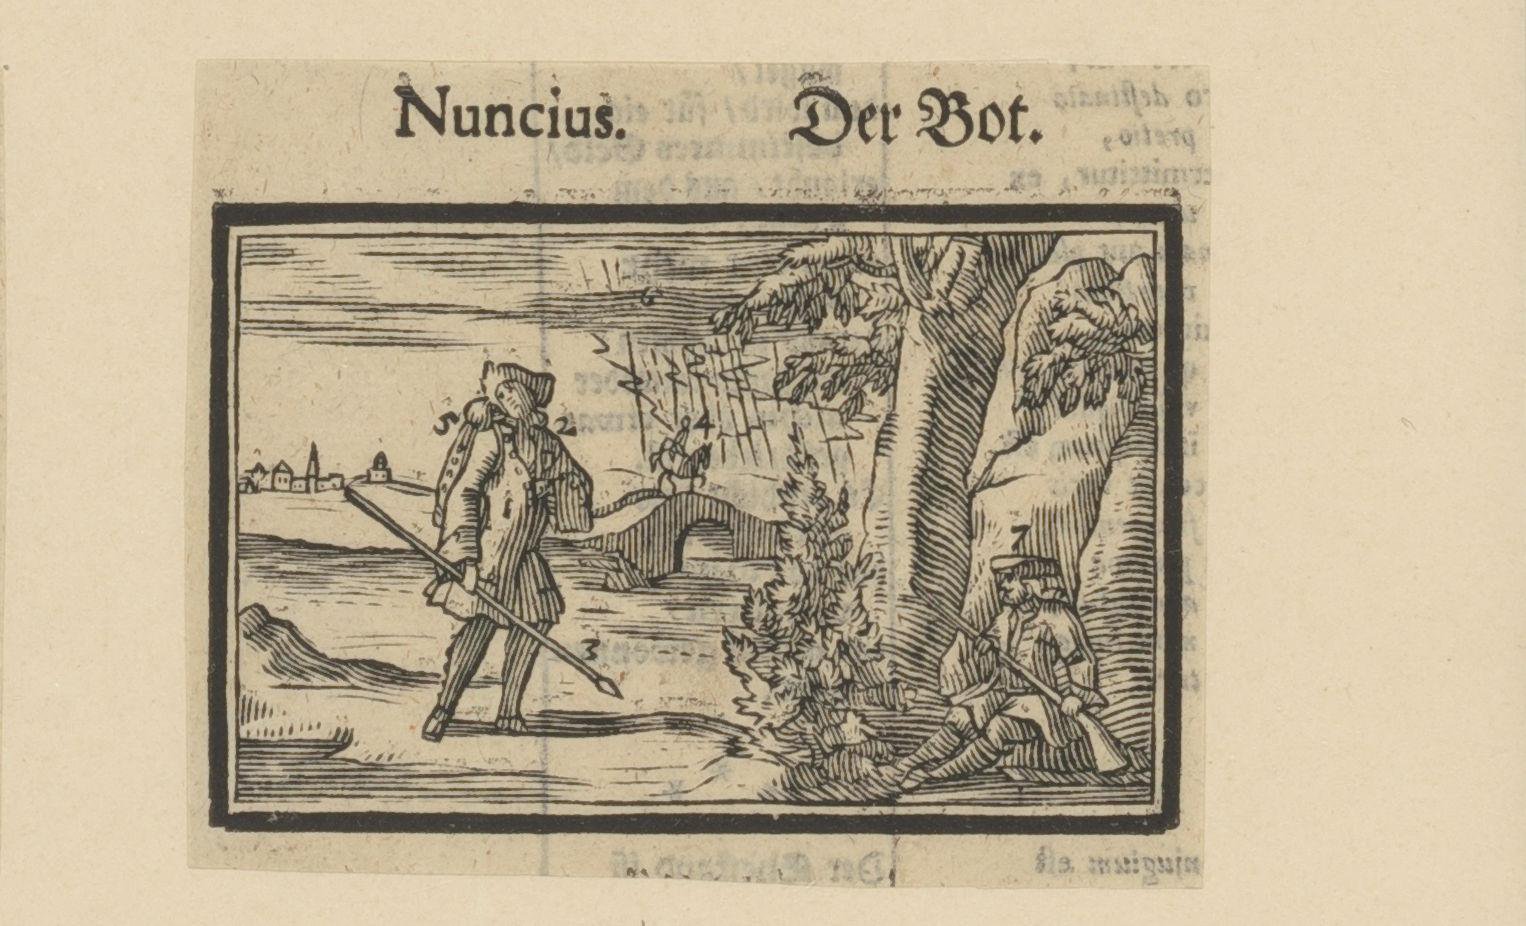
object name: print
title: Koerier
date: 1719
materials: paper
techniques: letterpress printing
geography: nuremberg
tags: handicrafts, craftsman at work, shoe-maker, cobbler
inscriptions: collector's mark: Lugt 1641, stamp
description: Een landschap met een boodschapper met een insigne op zijn borst. Op zijn rug draagt hij de boodschappen. In zijn hand een speer. Op de achtergrond een boodschapper te paard en rechts een struikrover met een geweer. Onderwerpsrubrieken binnen de Atlas Zeden en Gewoonten: Handel, Nijverheid en Verkeer, Beroep en bedrijf, Complete suites.